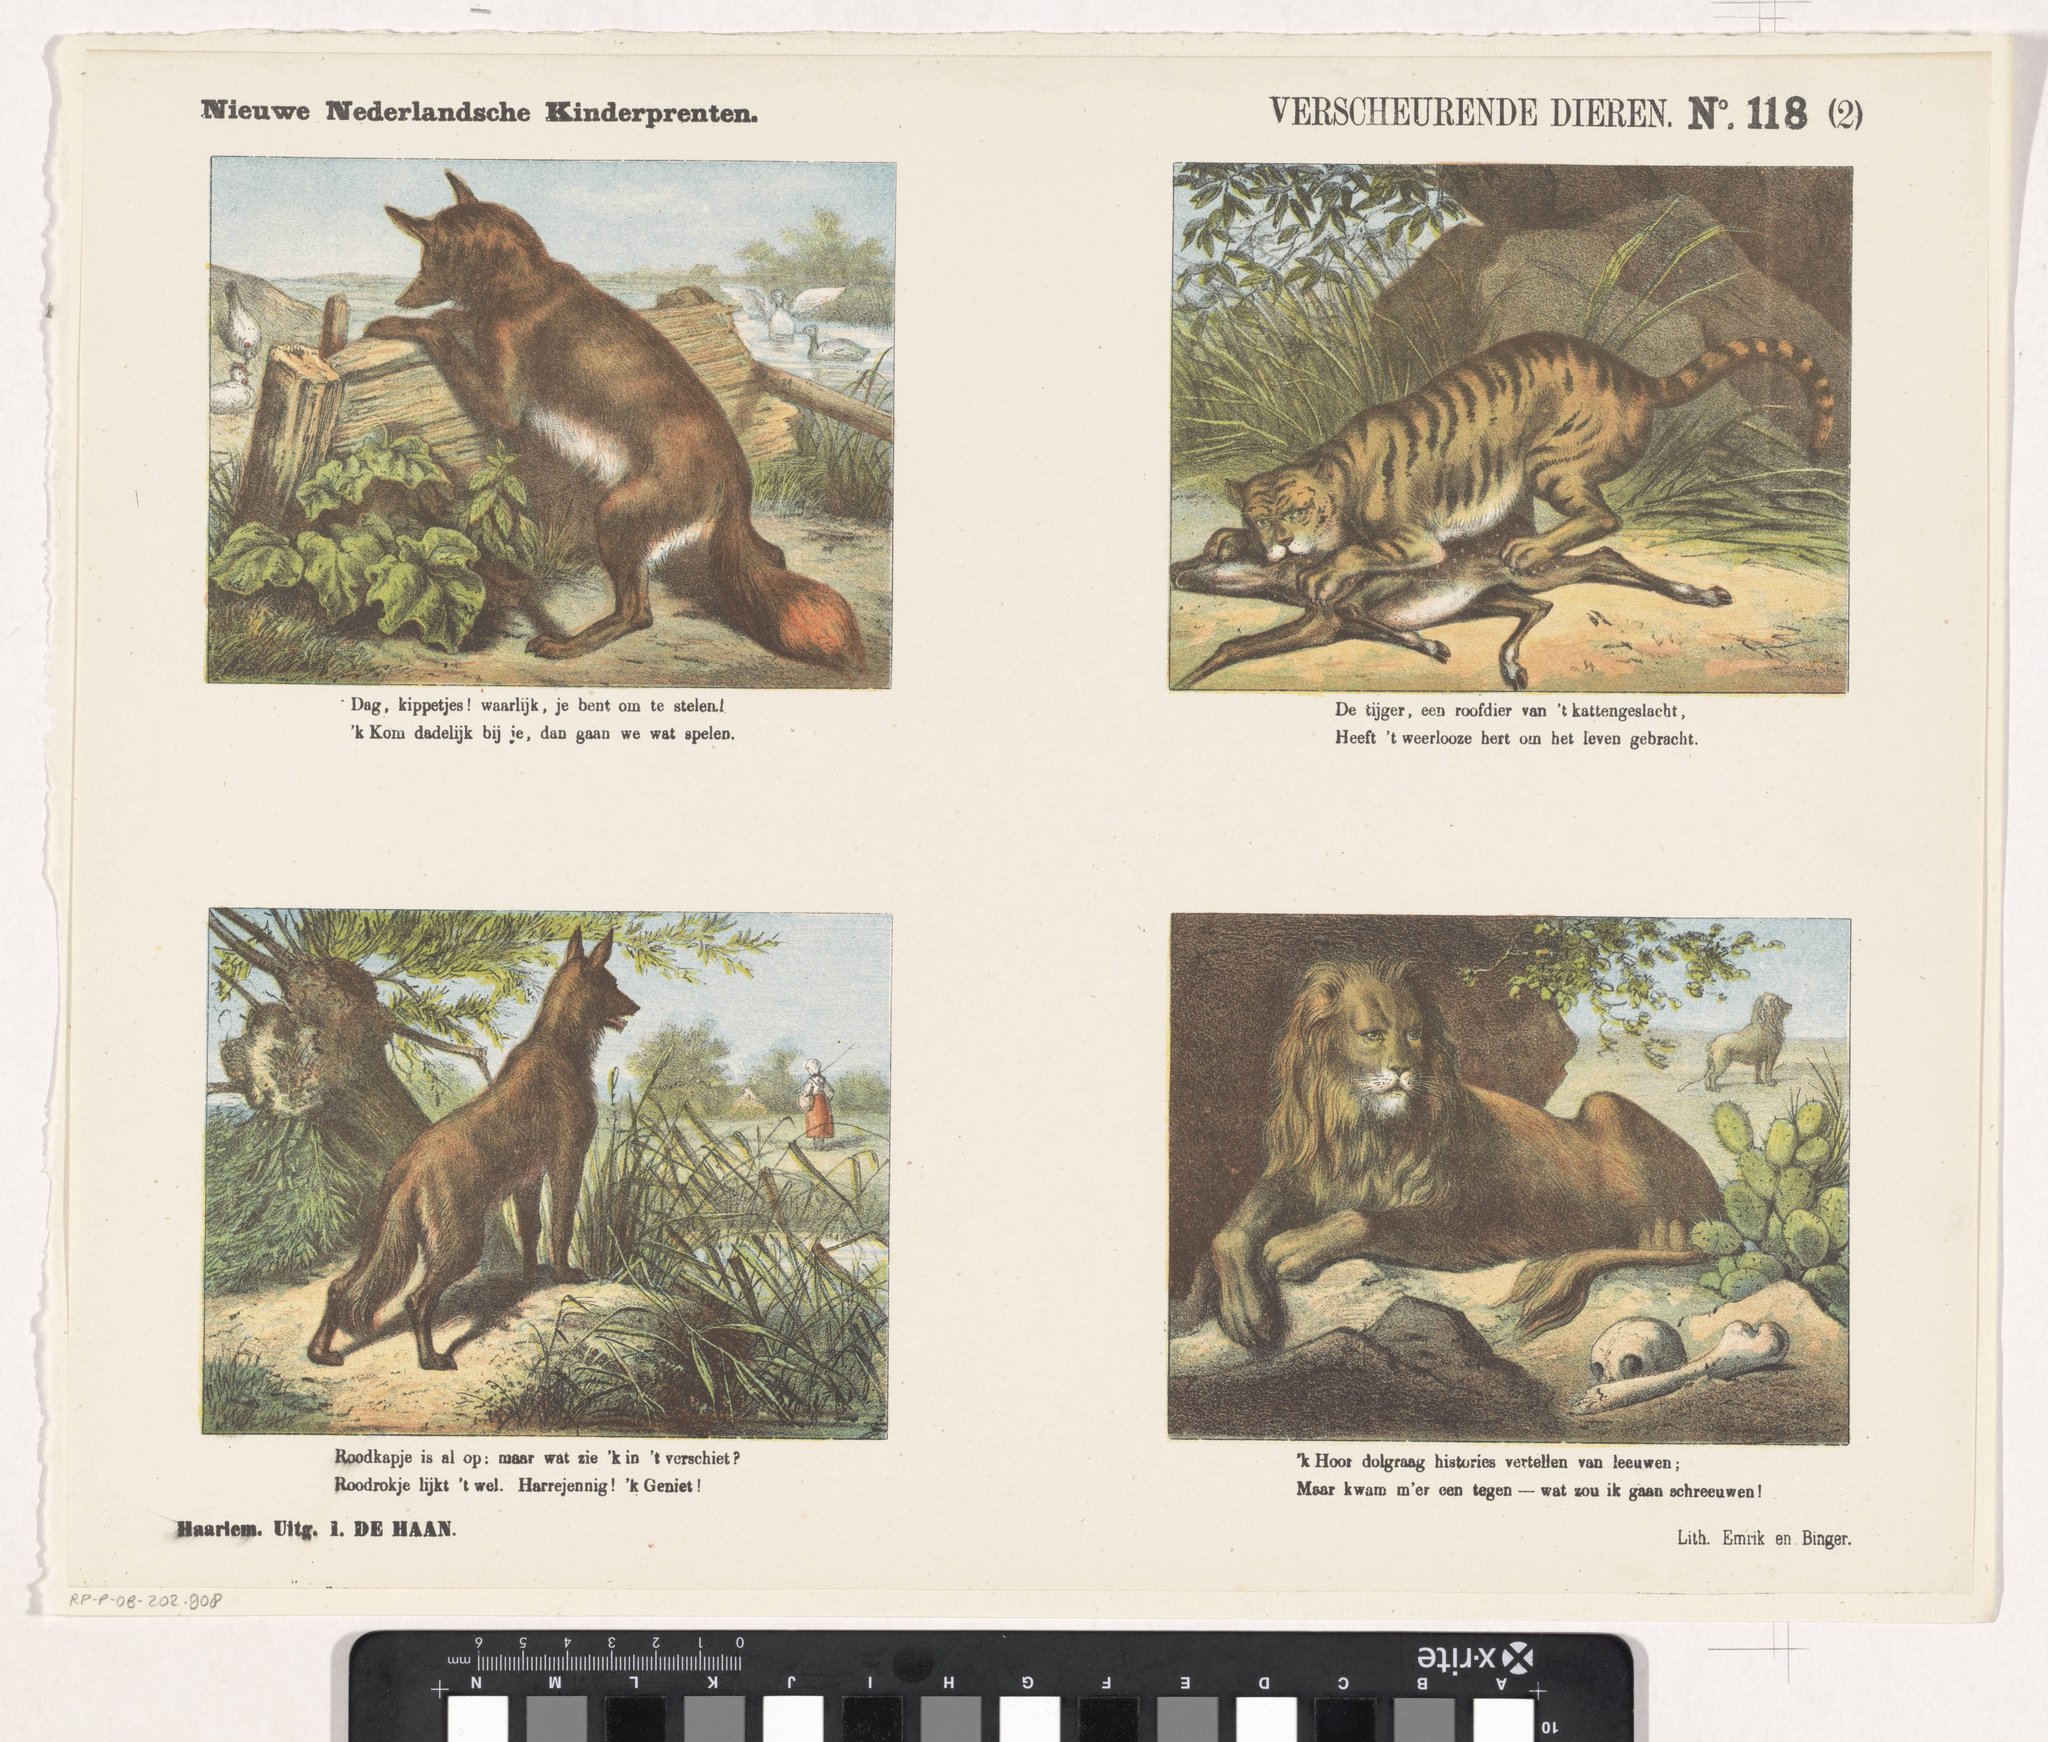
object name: print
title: Verscheurende dieren / (2)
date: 1875-1903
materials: paper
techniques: lithograph, letterpress printing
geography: haarlem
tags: beasts of prey, predatory animals: tiger, animals, beasts of prey, predatory animals: lion, beasts of prey, predatory animals: fox, beasts of prey, predatory animals: wolf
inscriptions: collector's mark: Lugt 2760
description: Blad met 4 voorstellingen van een vos, een tijger, een wolf en een leeuw. Onder elke voorstelling een tweeregelig vers. Genummerd rechtsboven: No. 118.